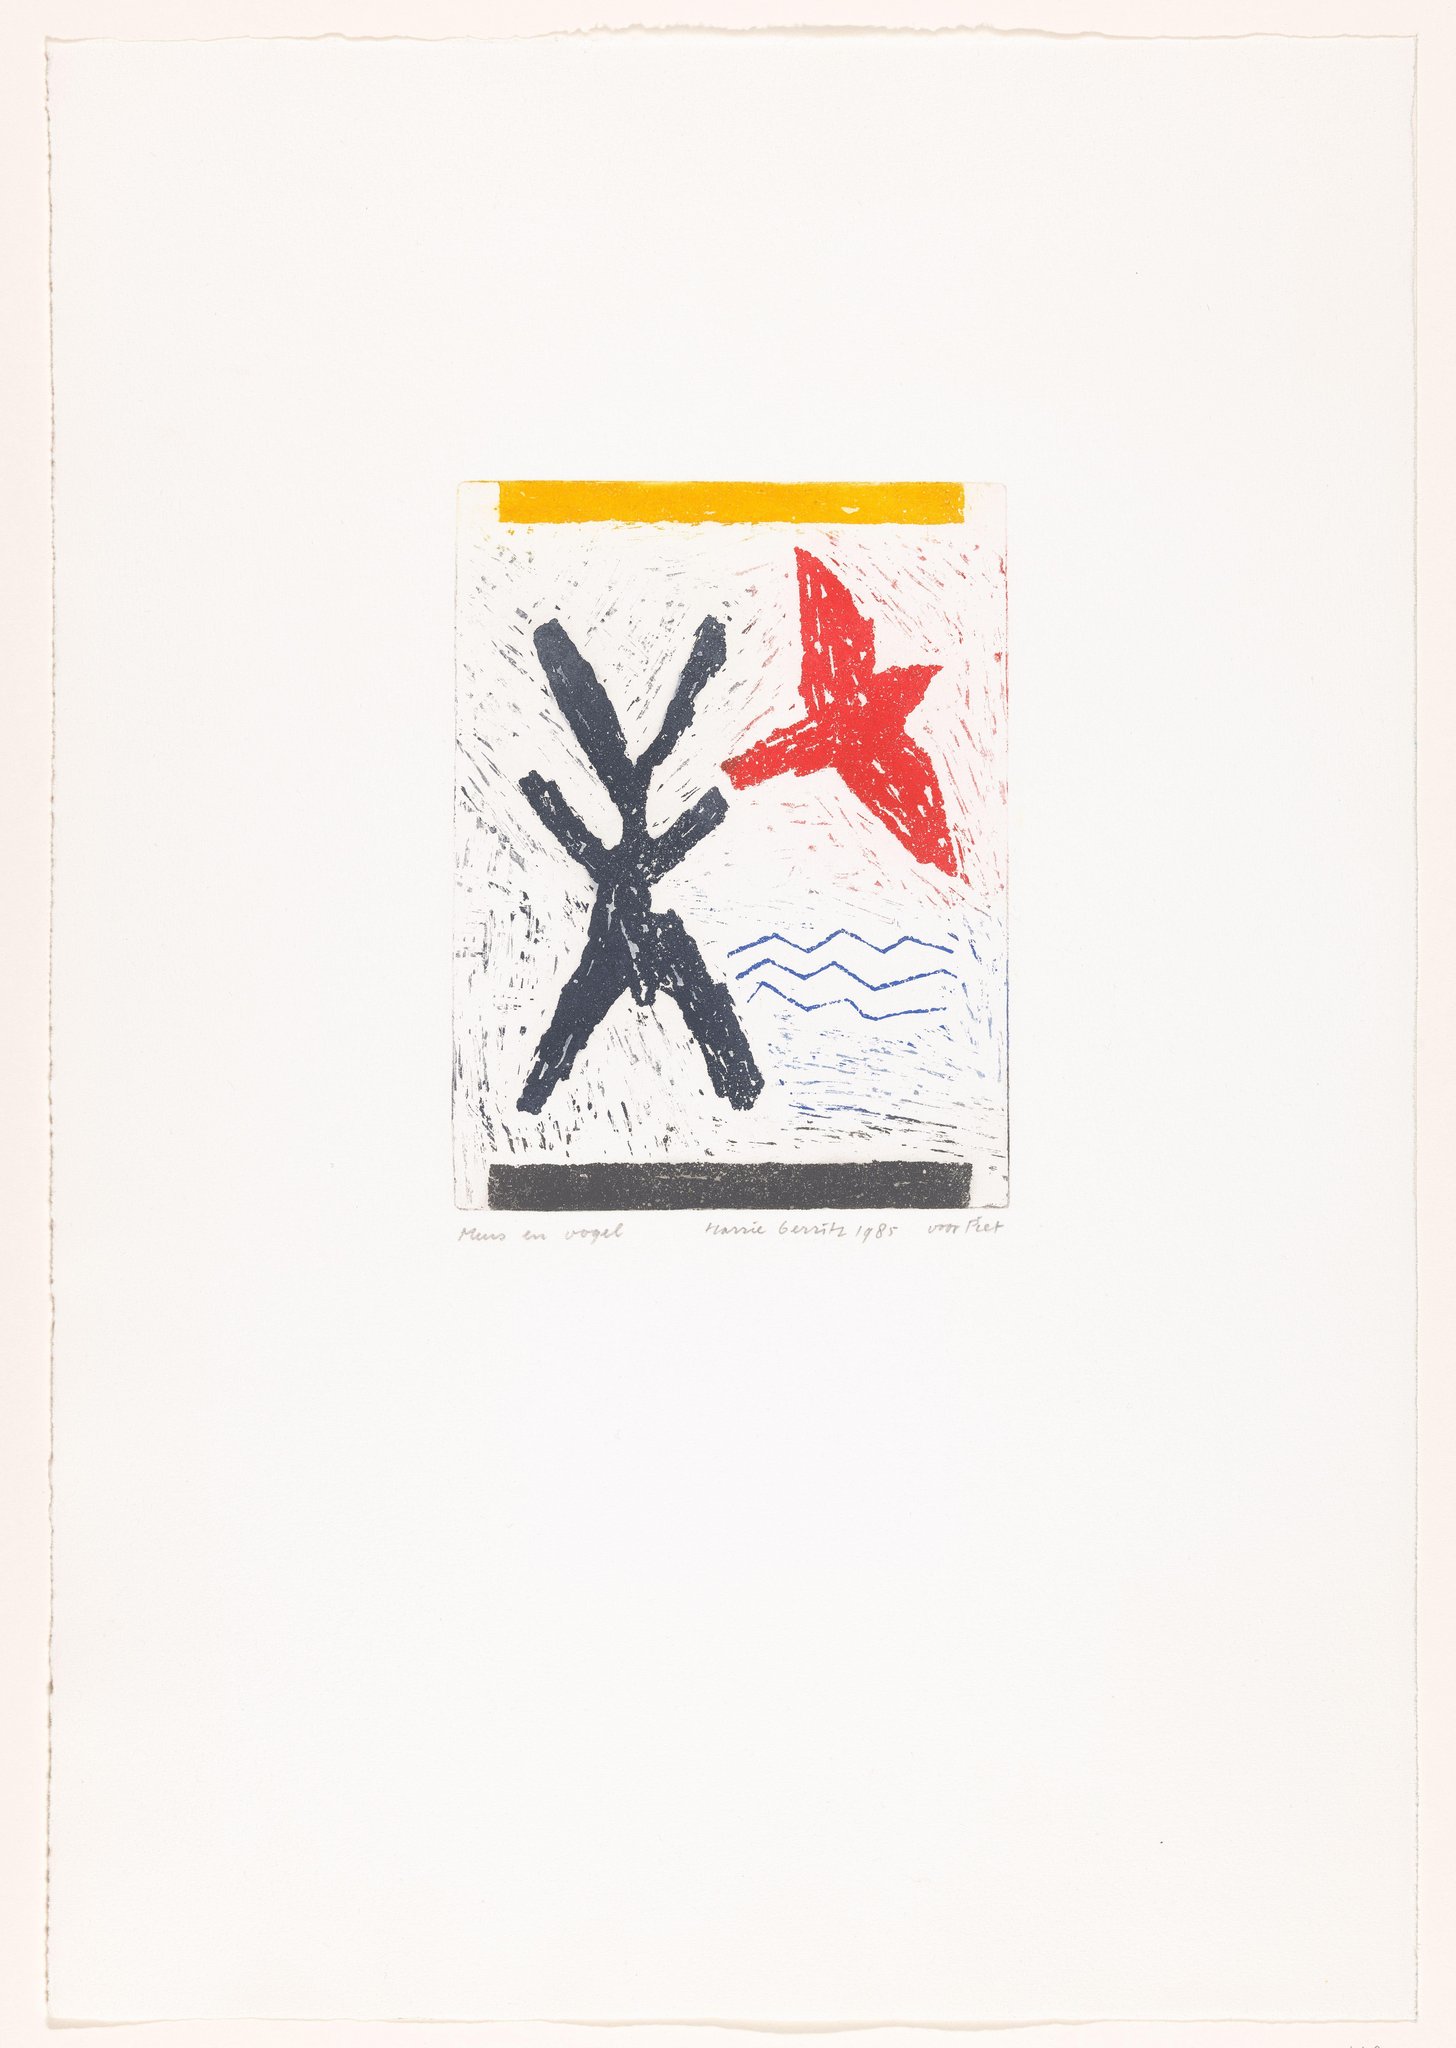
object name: print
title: Mens en vogel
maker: harrie a. gerritz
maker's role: draughtsman, painter, print maker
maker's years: 1940-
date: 1985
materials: paper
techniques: aquatint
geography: amsterdam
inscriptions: signature and date: ‘Harrie Gerritz 1985’, inscription: ‘voor Piet’, title: ‘Mens en vogel’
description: Schematisch en schetsmatig opgezetten mens in zwart en vogel in rood.